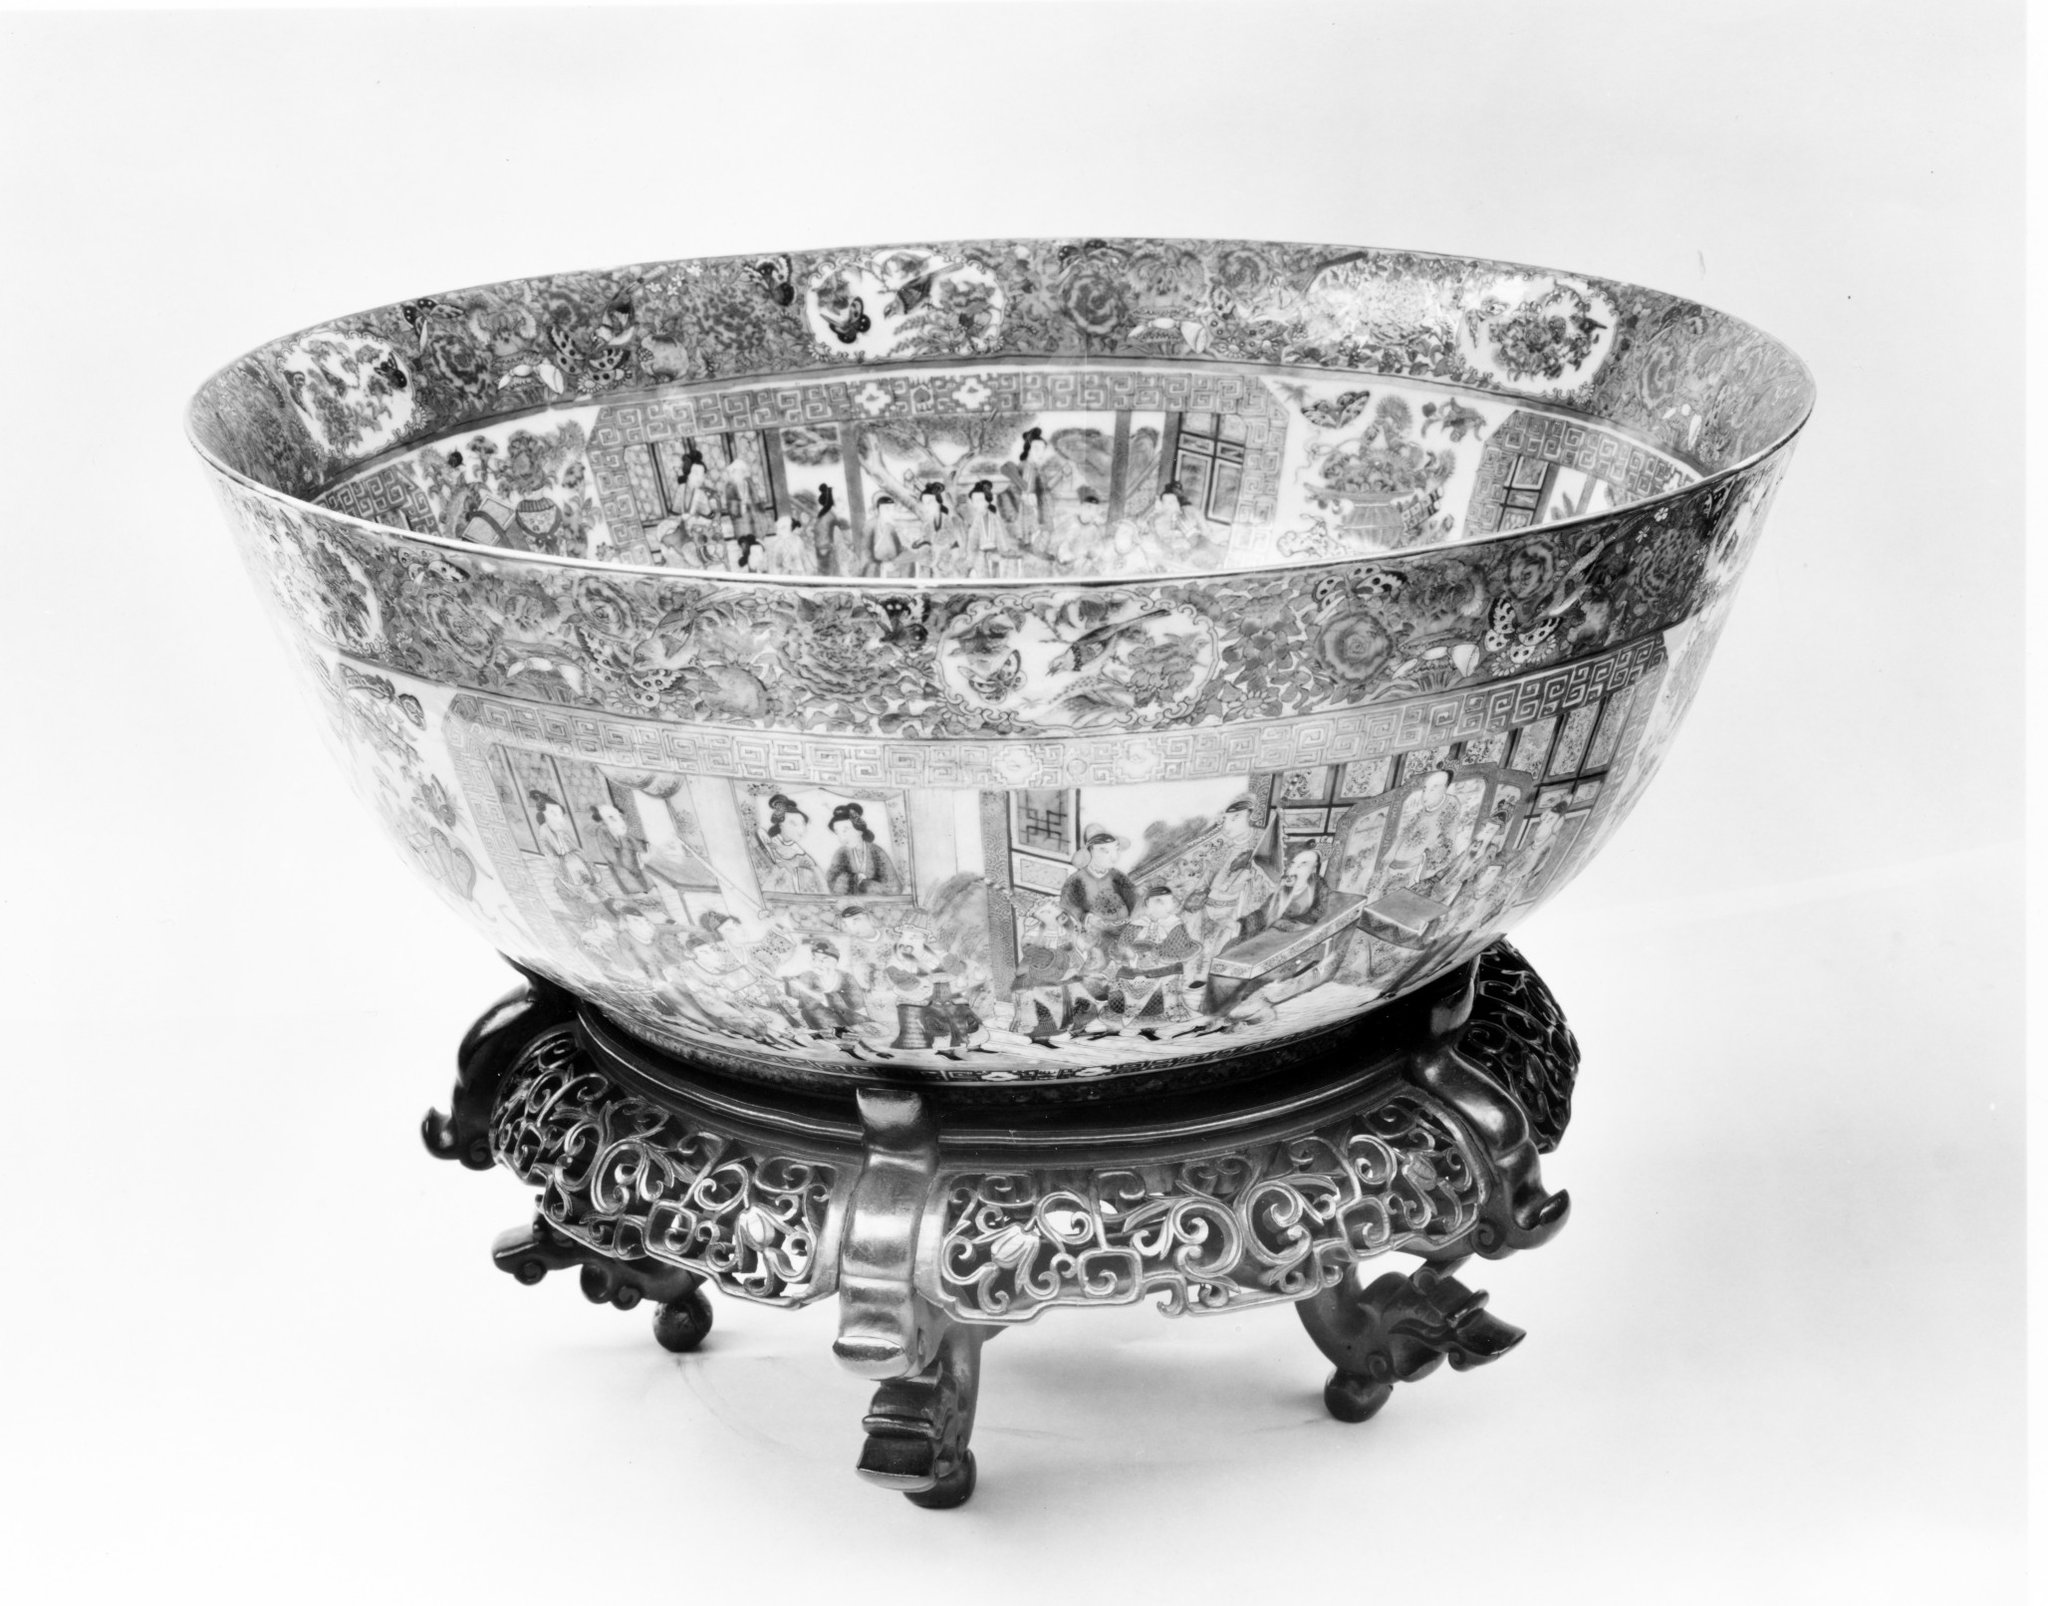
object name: bowl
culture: chinese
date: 1825-1840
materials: porcelain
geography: china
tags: men,women